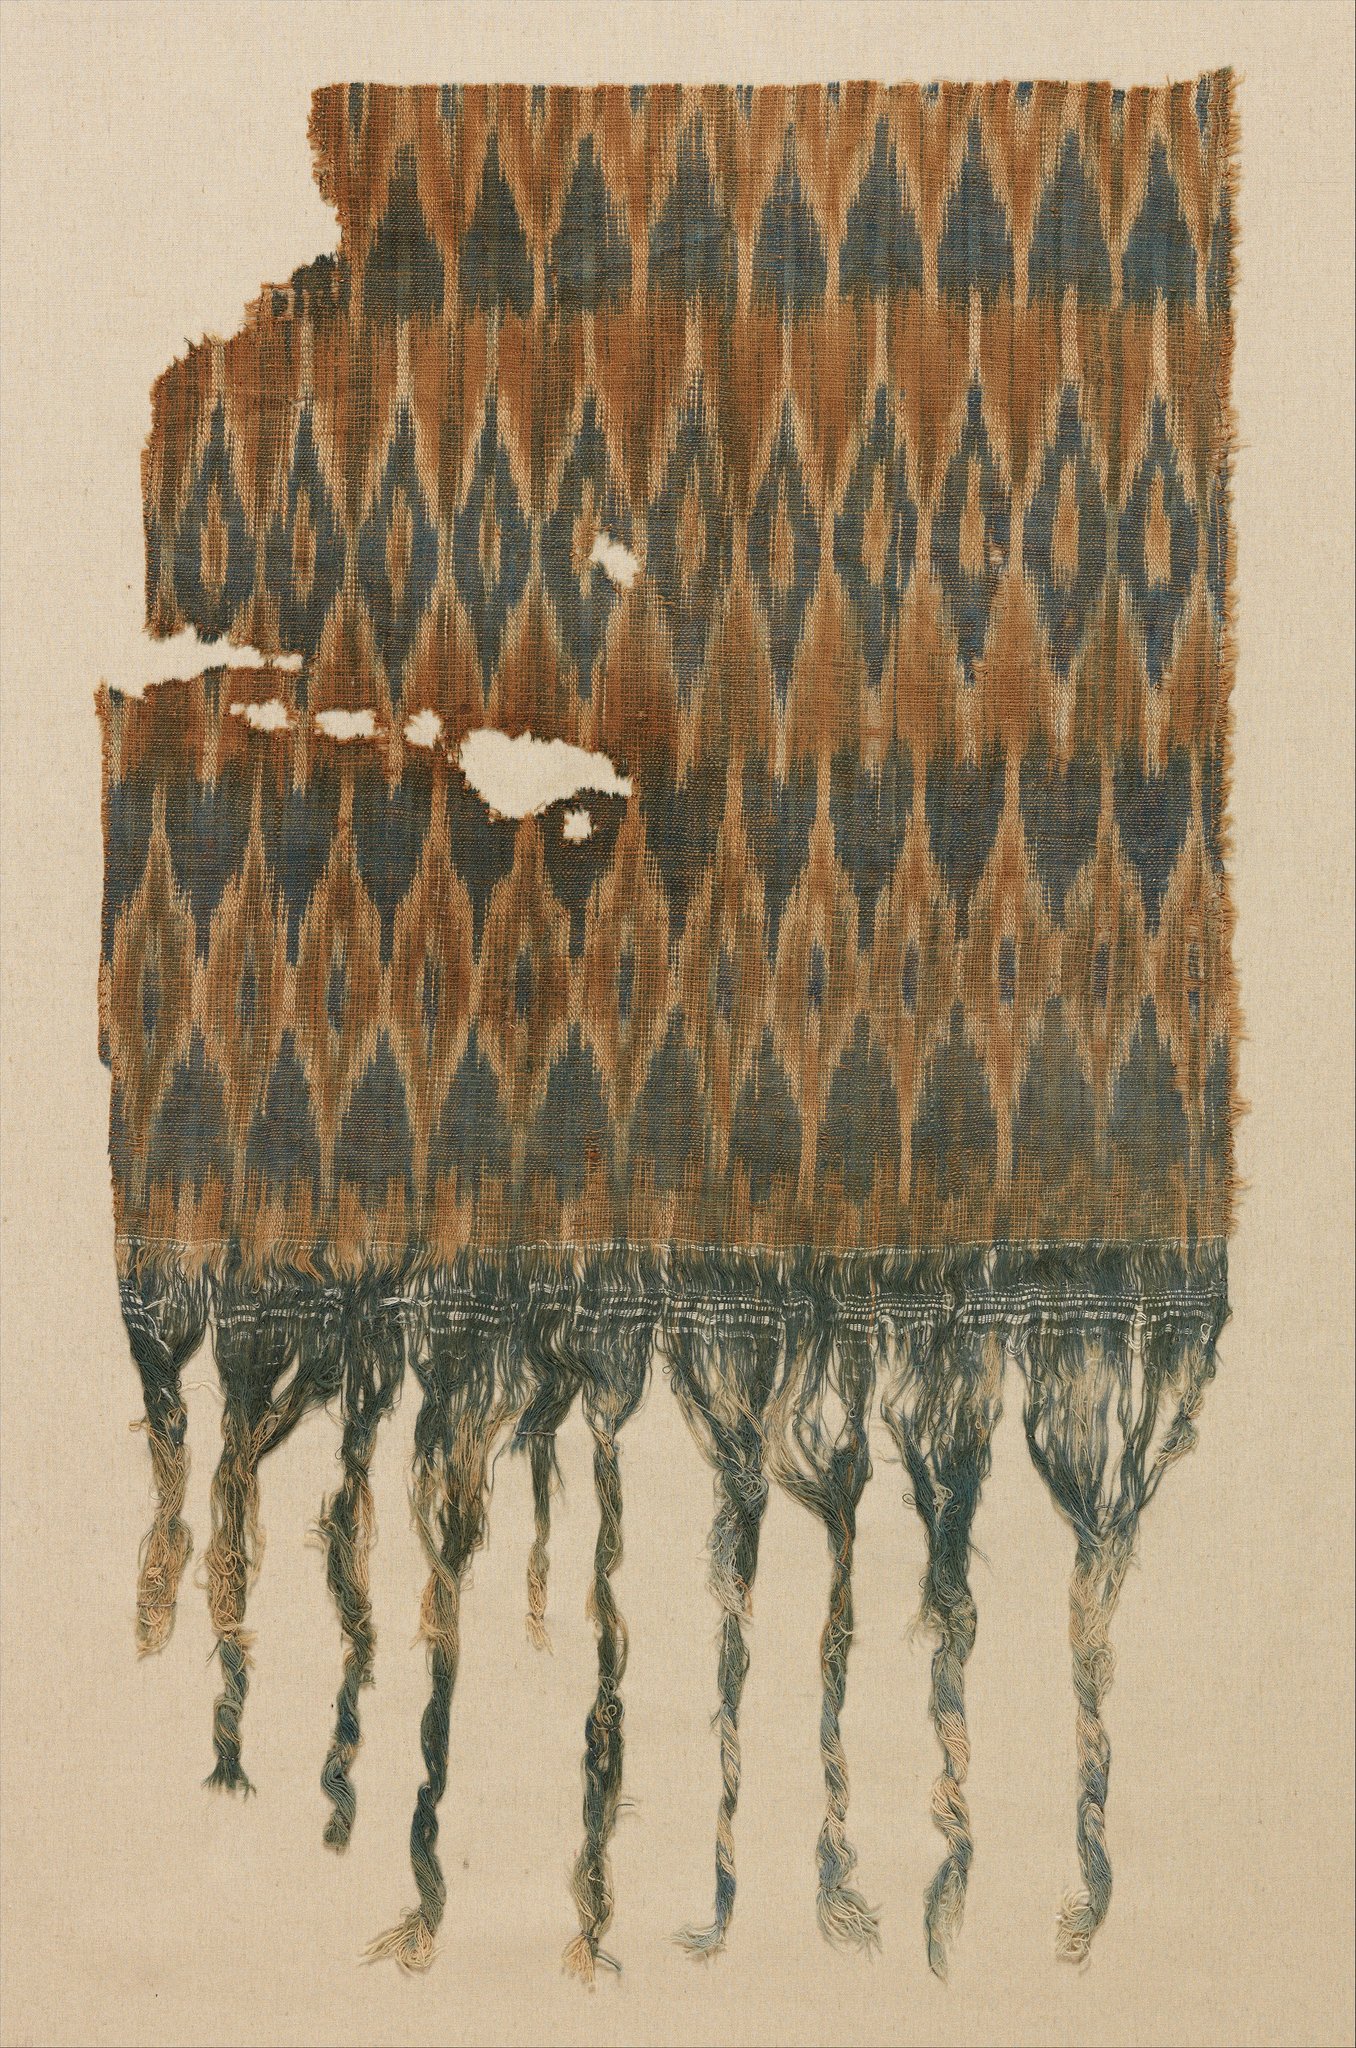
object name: textile fragment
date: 901-1000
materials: cotton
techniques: dyeing, embroidery, weave, resist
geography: yemen